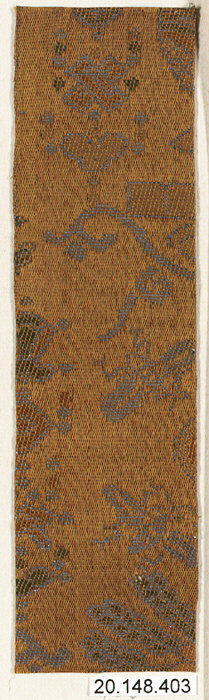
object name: piece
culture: japanese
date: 1501-1600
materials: silk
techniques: compound weave